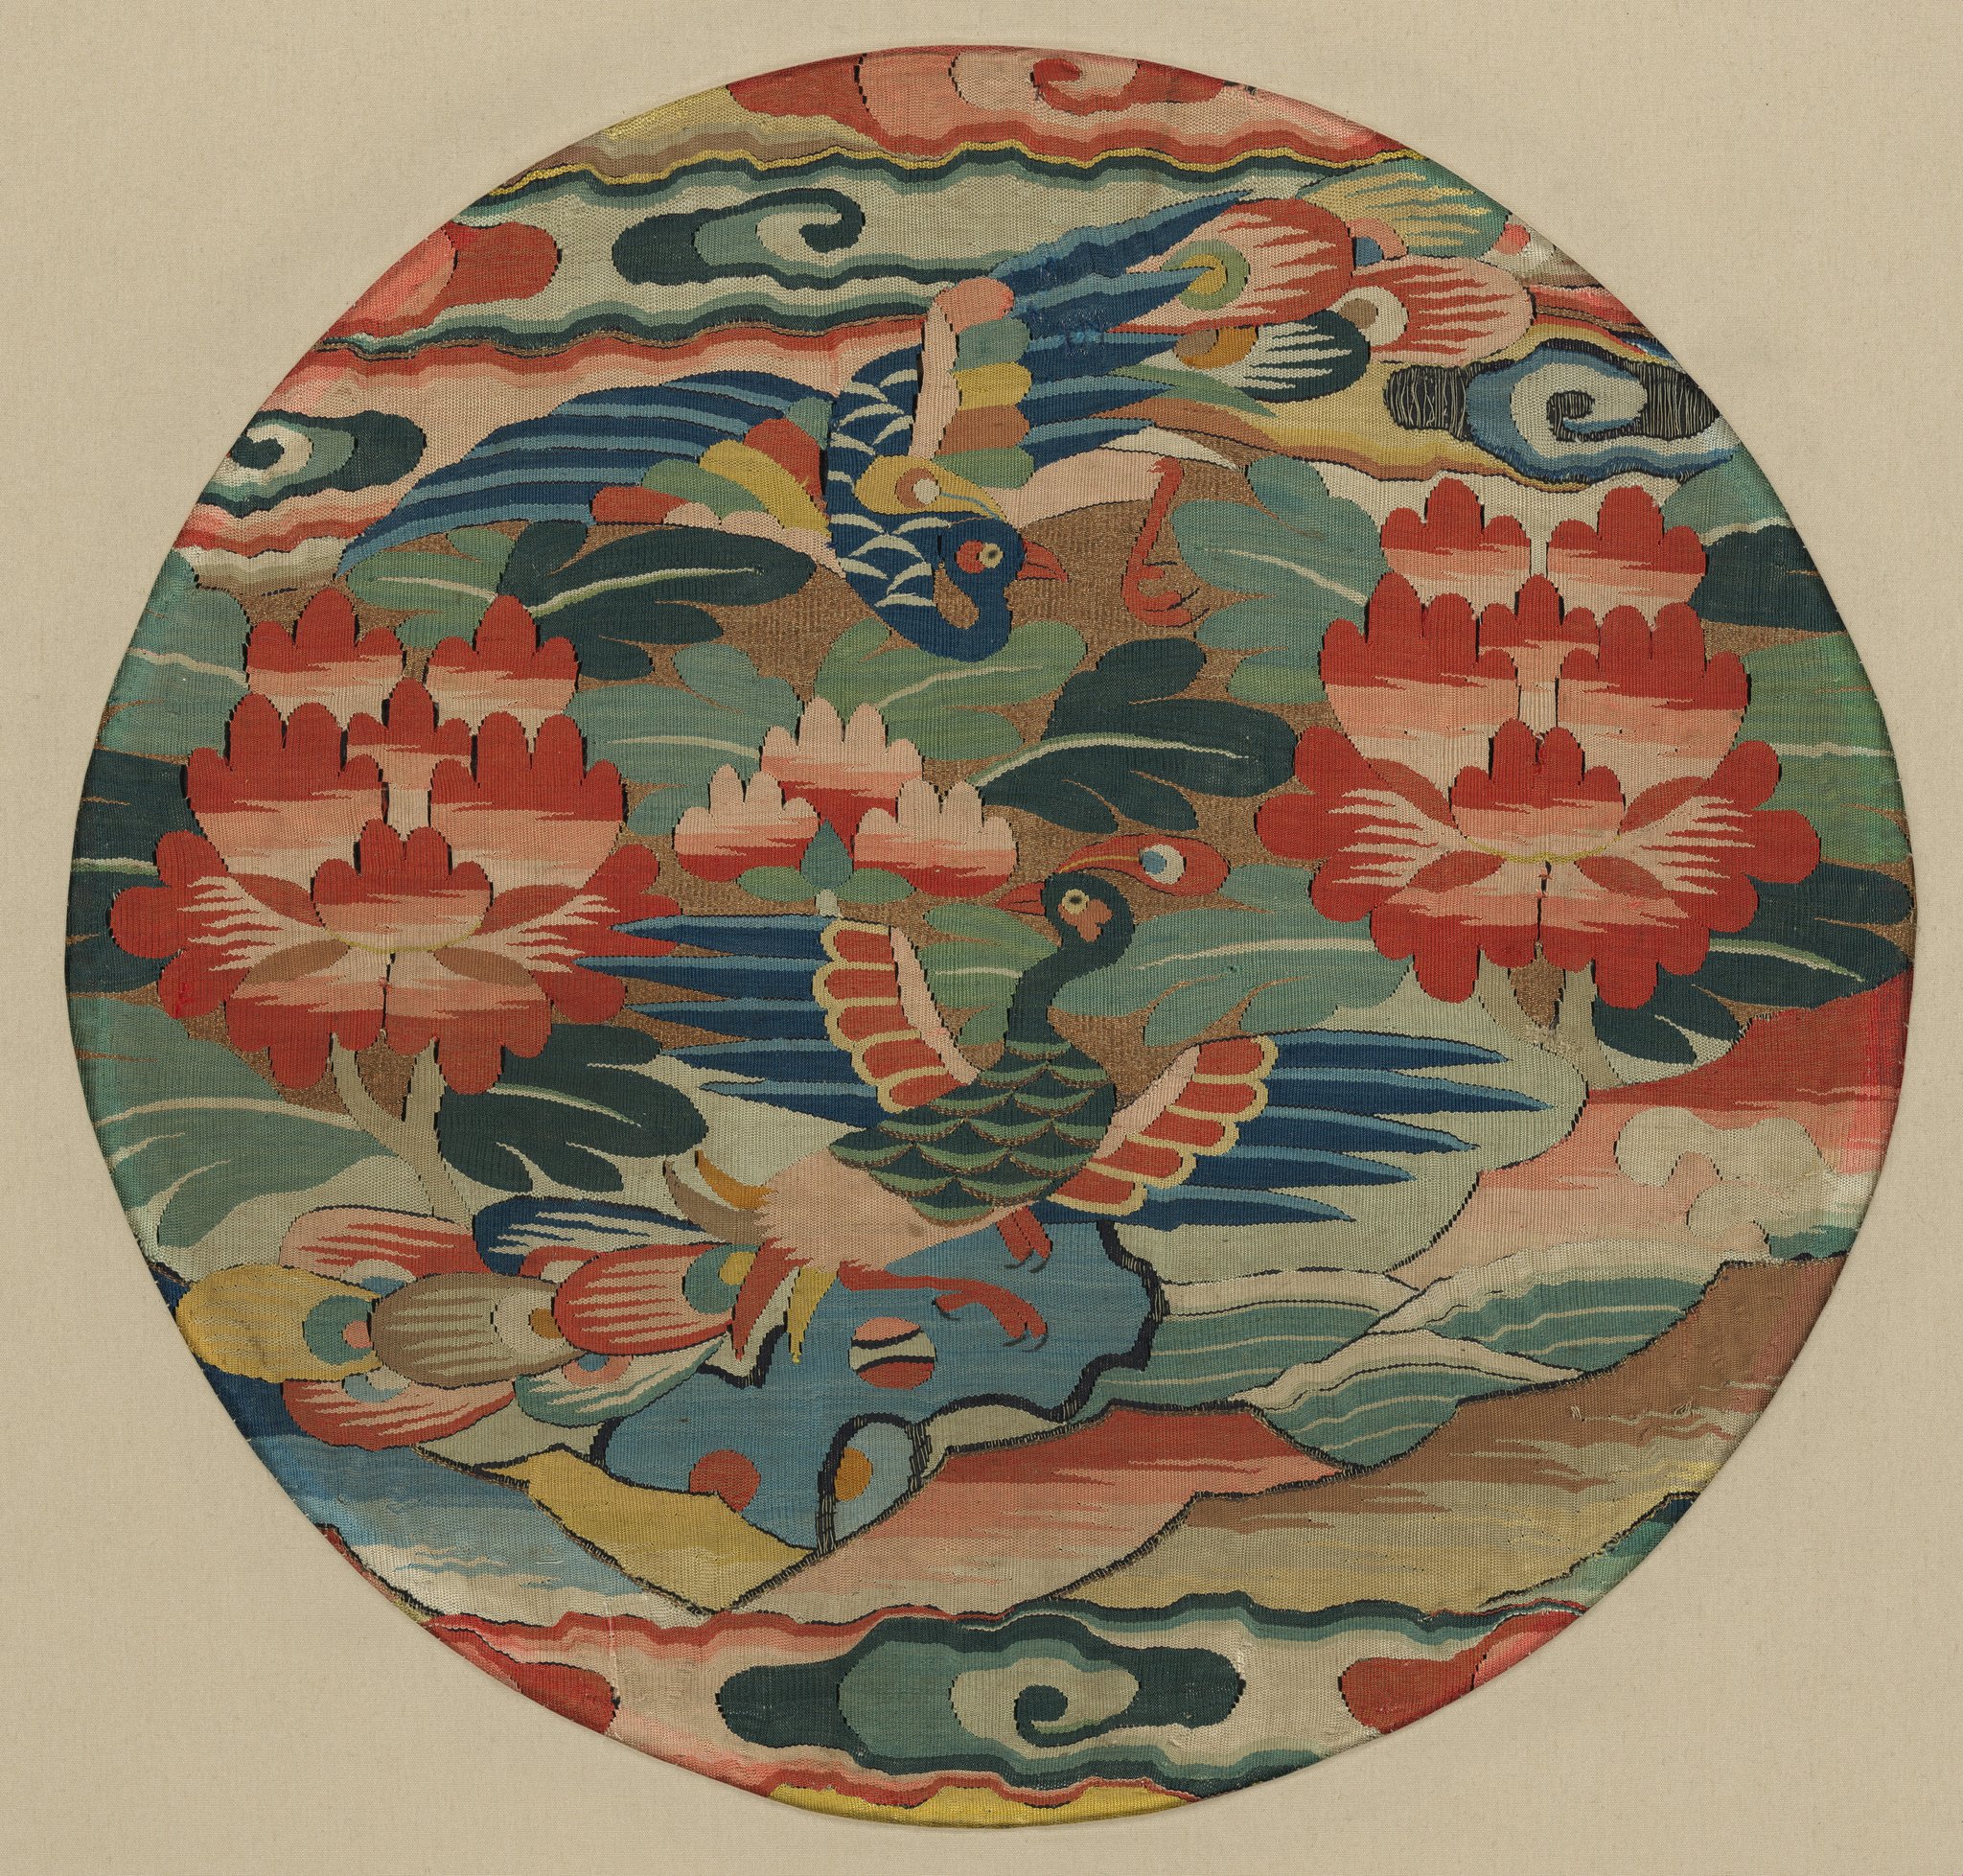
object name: medallion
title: Medallion with two peacocks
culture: chinese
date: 1501-1600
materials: metal thread, silk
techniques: tapestry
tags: peacocks,flowers